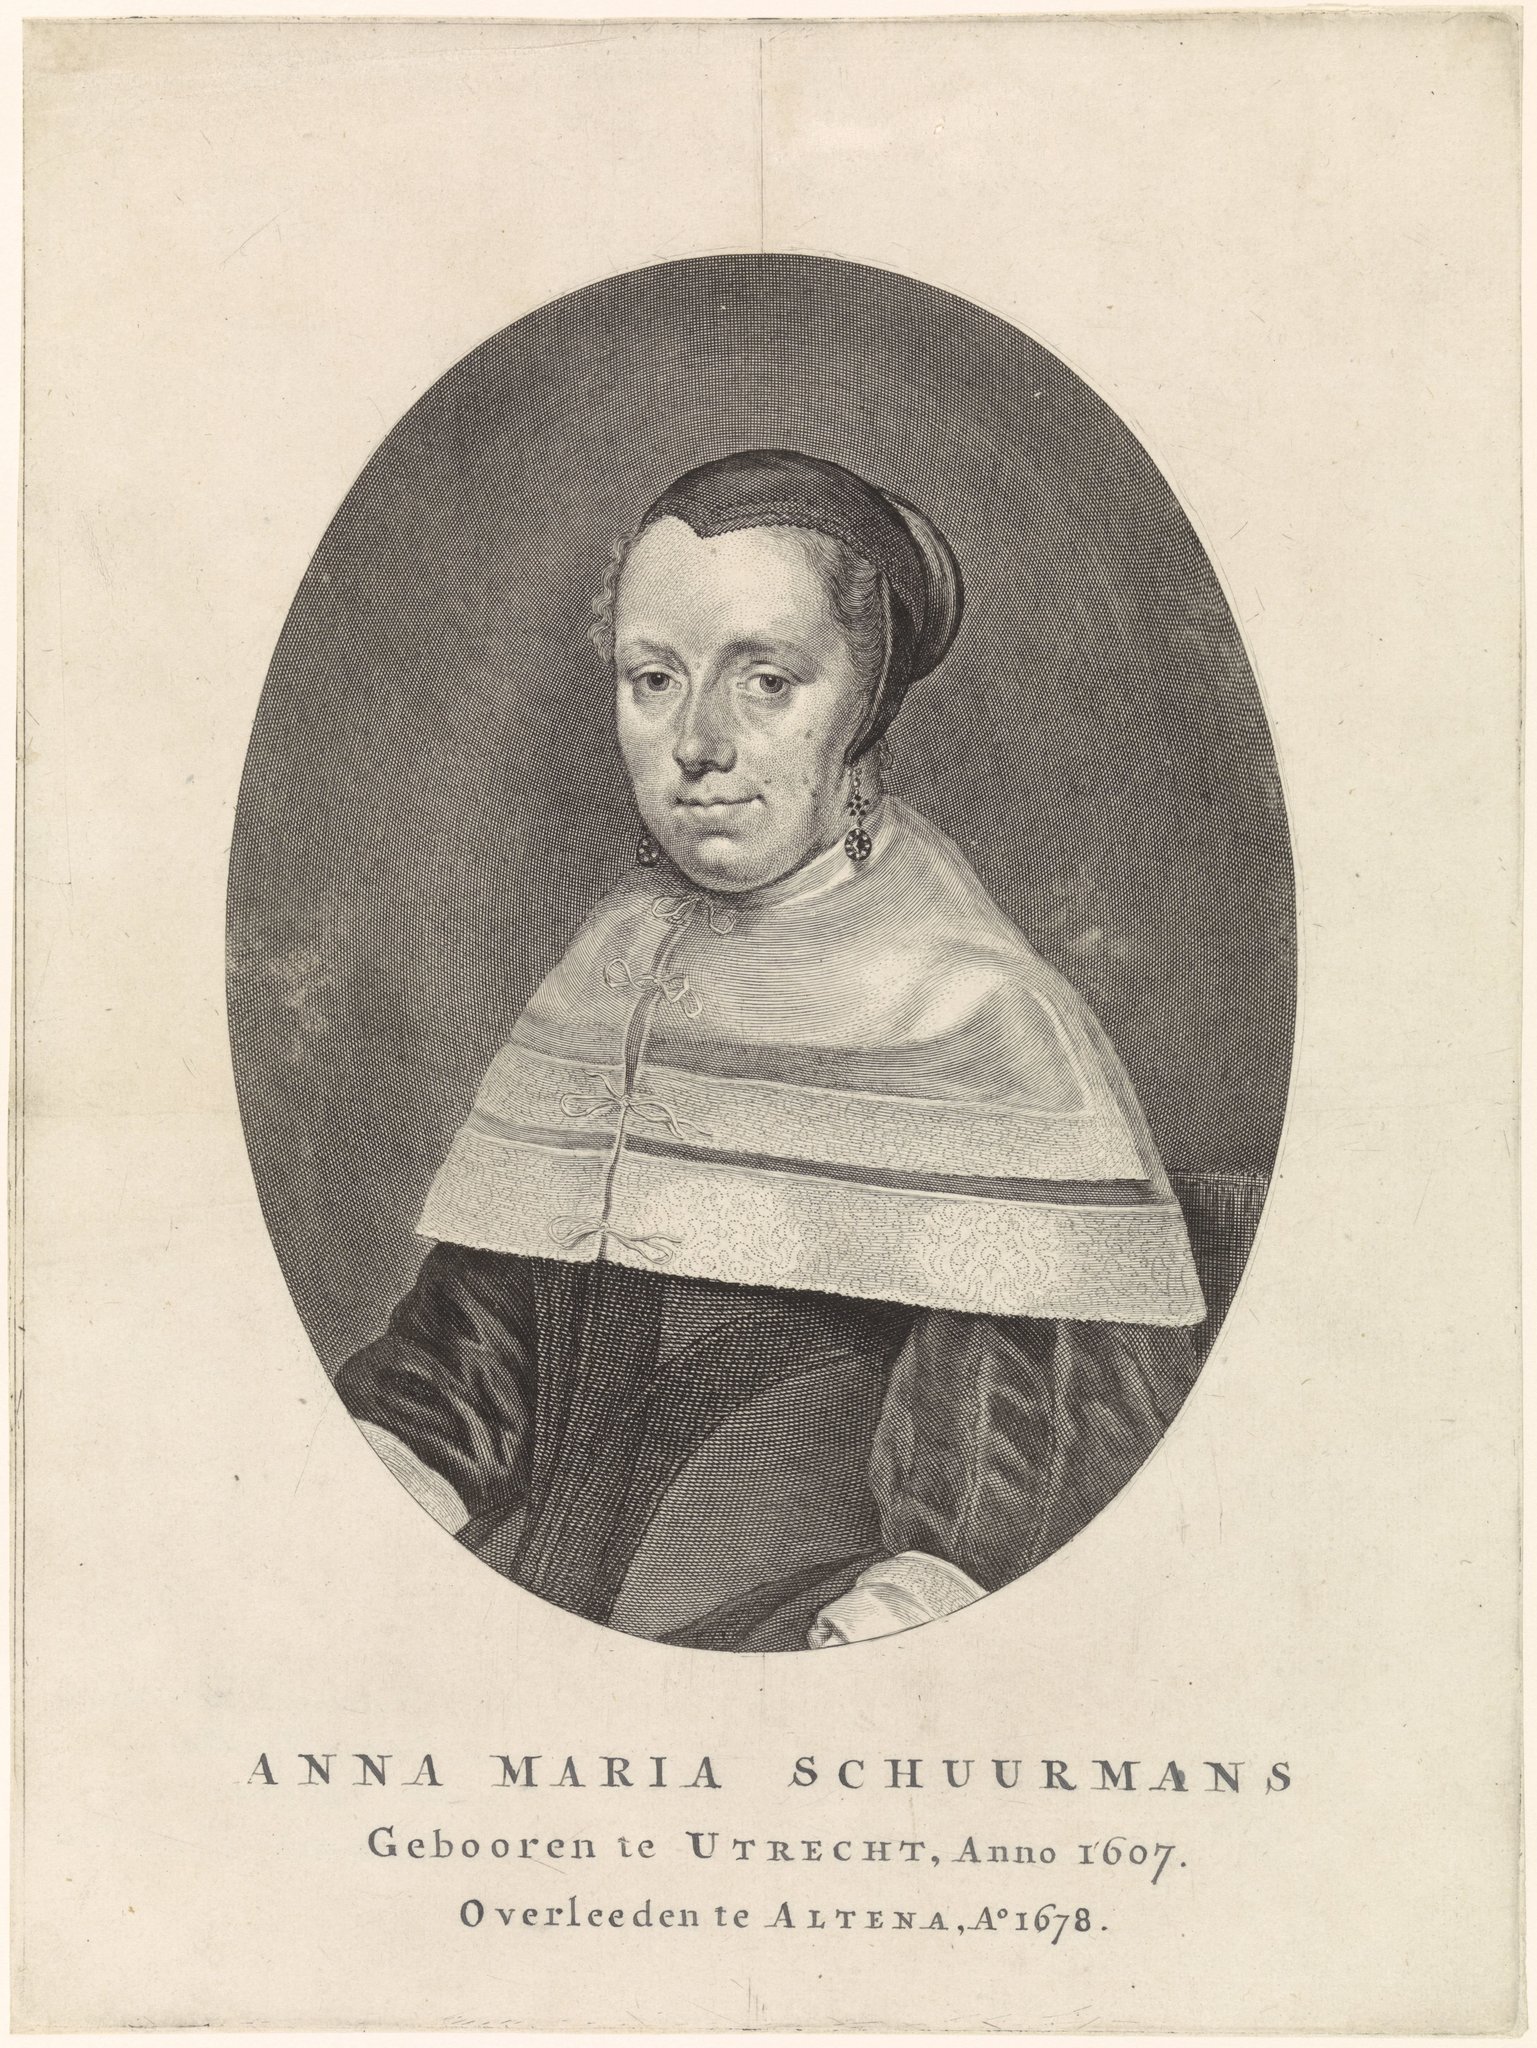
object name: print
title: Portret van Maria Matham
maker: theodor matham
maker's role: draughtsman, print maker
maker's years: 1605-1676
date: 1615-1676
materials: paper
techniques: engraving, pen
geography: northern netherlands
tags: maria matham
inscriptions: caption: ‘Anna Maria Schuurmans/ Gebooren te Utrecht, Anno 1607./ Overleeden te Altena, Ao 1678.’, collector's mark: Lugt 2228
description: Het onderschrift met de vermelding 'Anna Maria Schuurmans ....' is met pen in zwarte inkt toegevoegd (getekend).